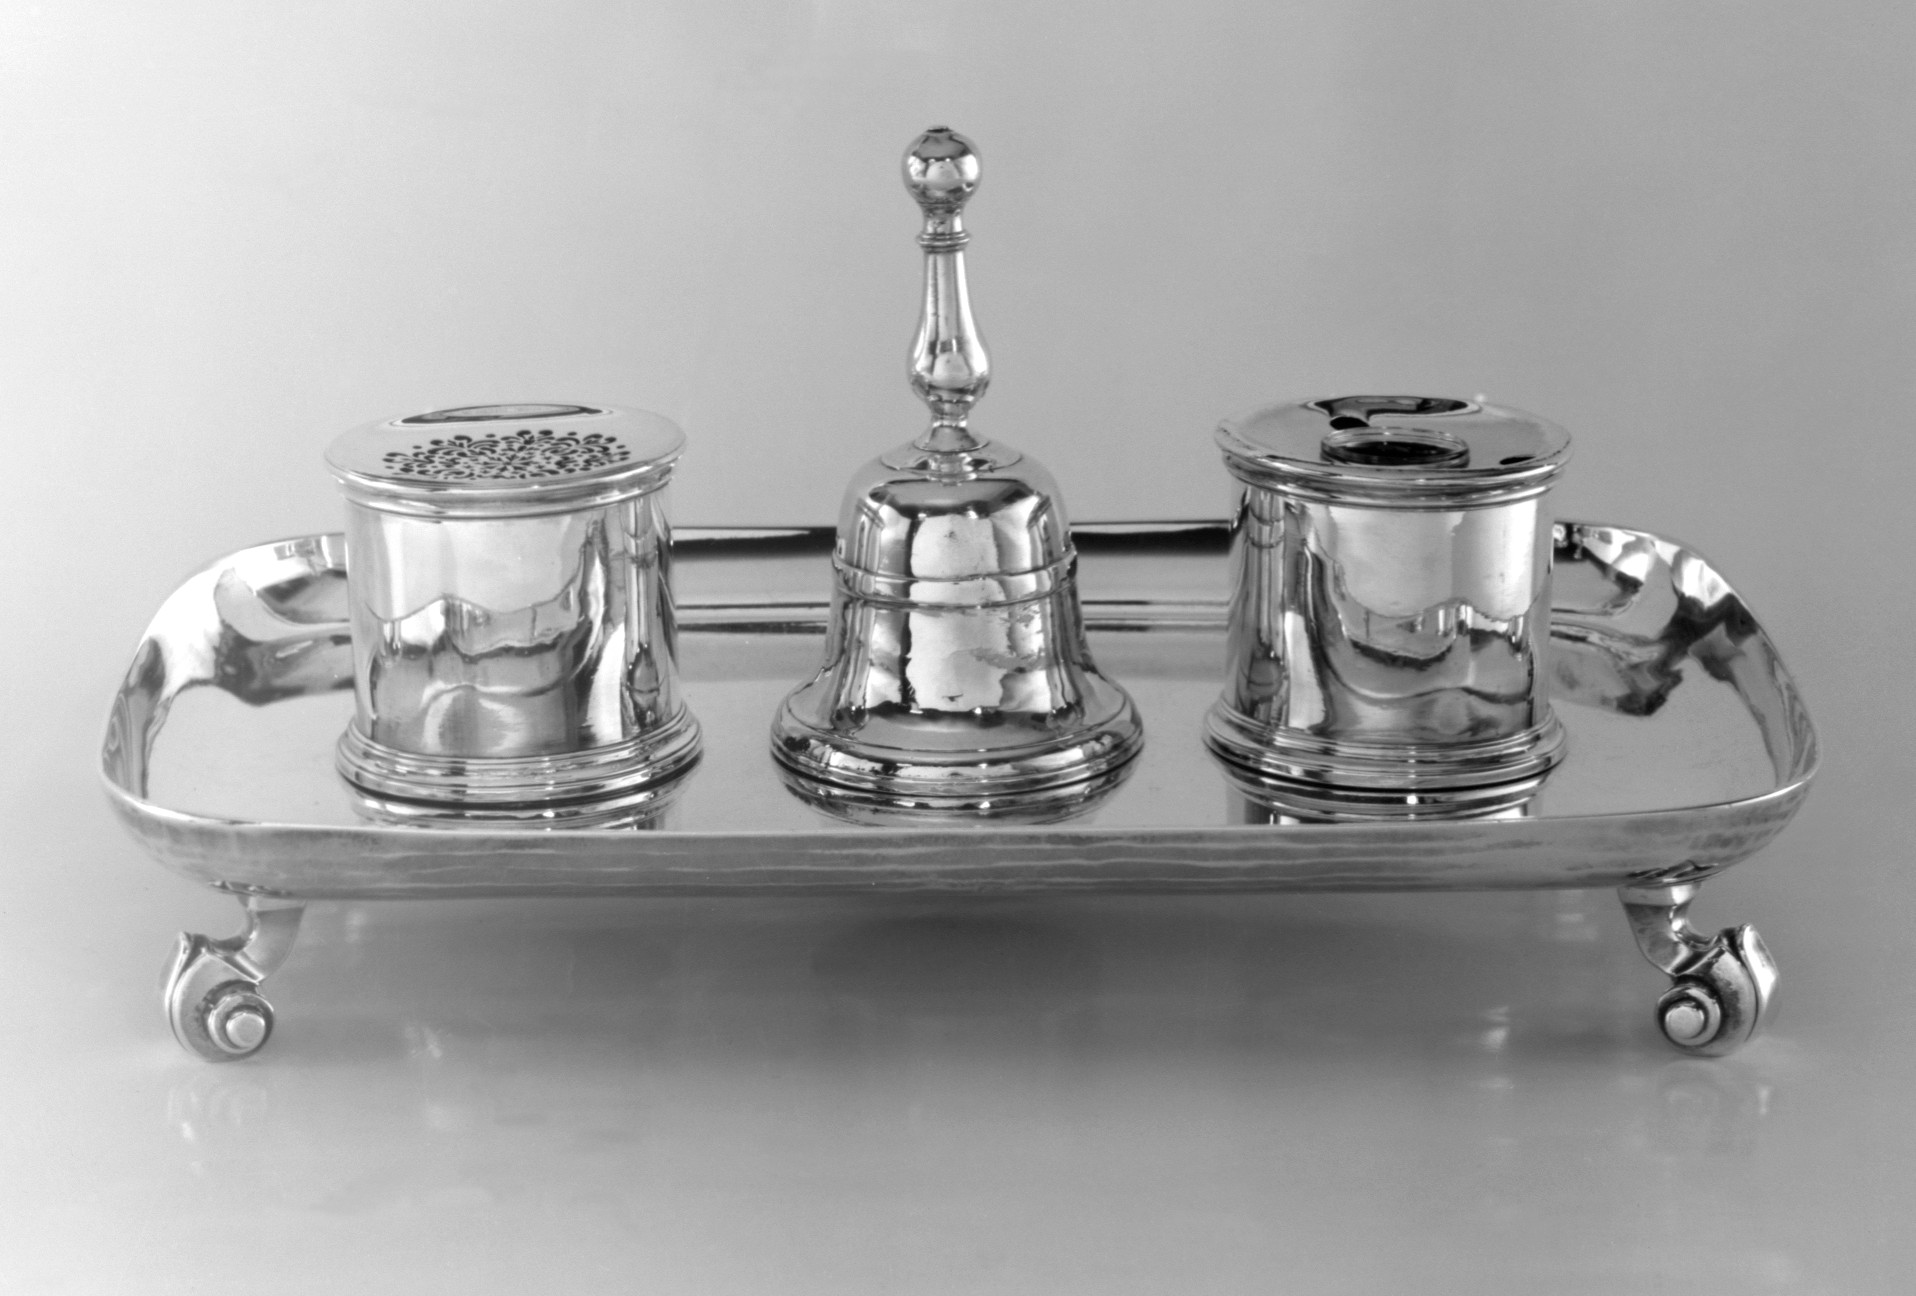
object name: inkstand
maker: simon pantin i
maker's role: maker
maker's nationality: british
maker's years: 1672-1728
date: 1725-1726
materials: silver